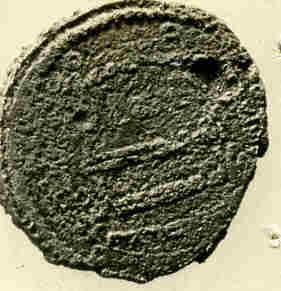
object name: coin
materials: copper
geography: iran